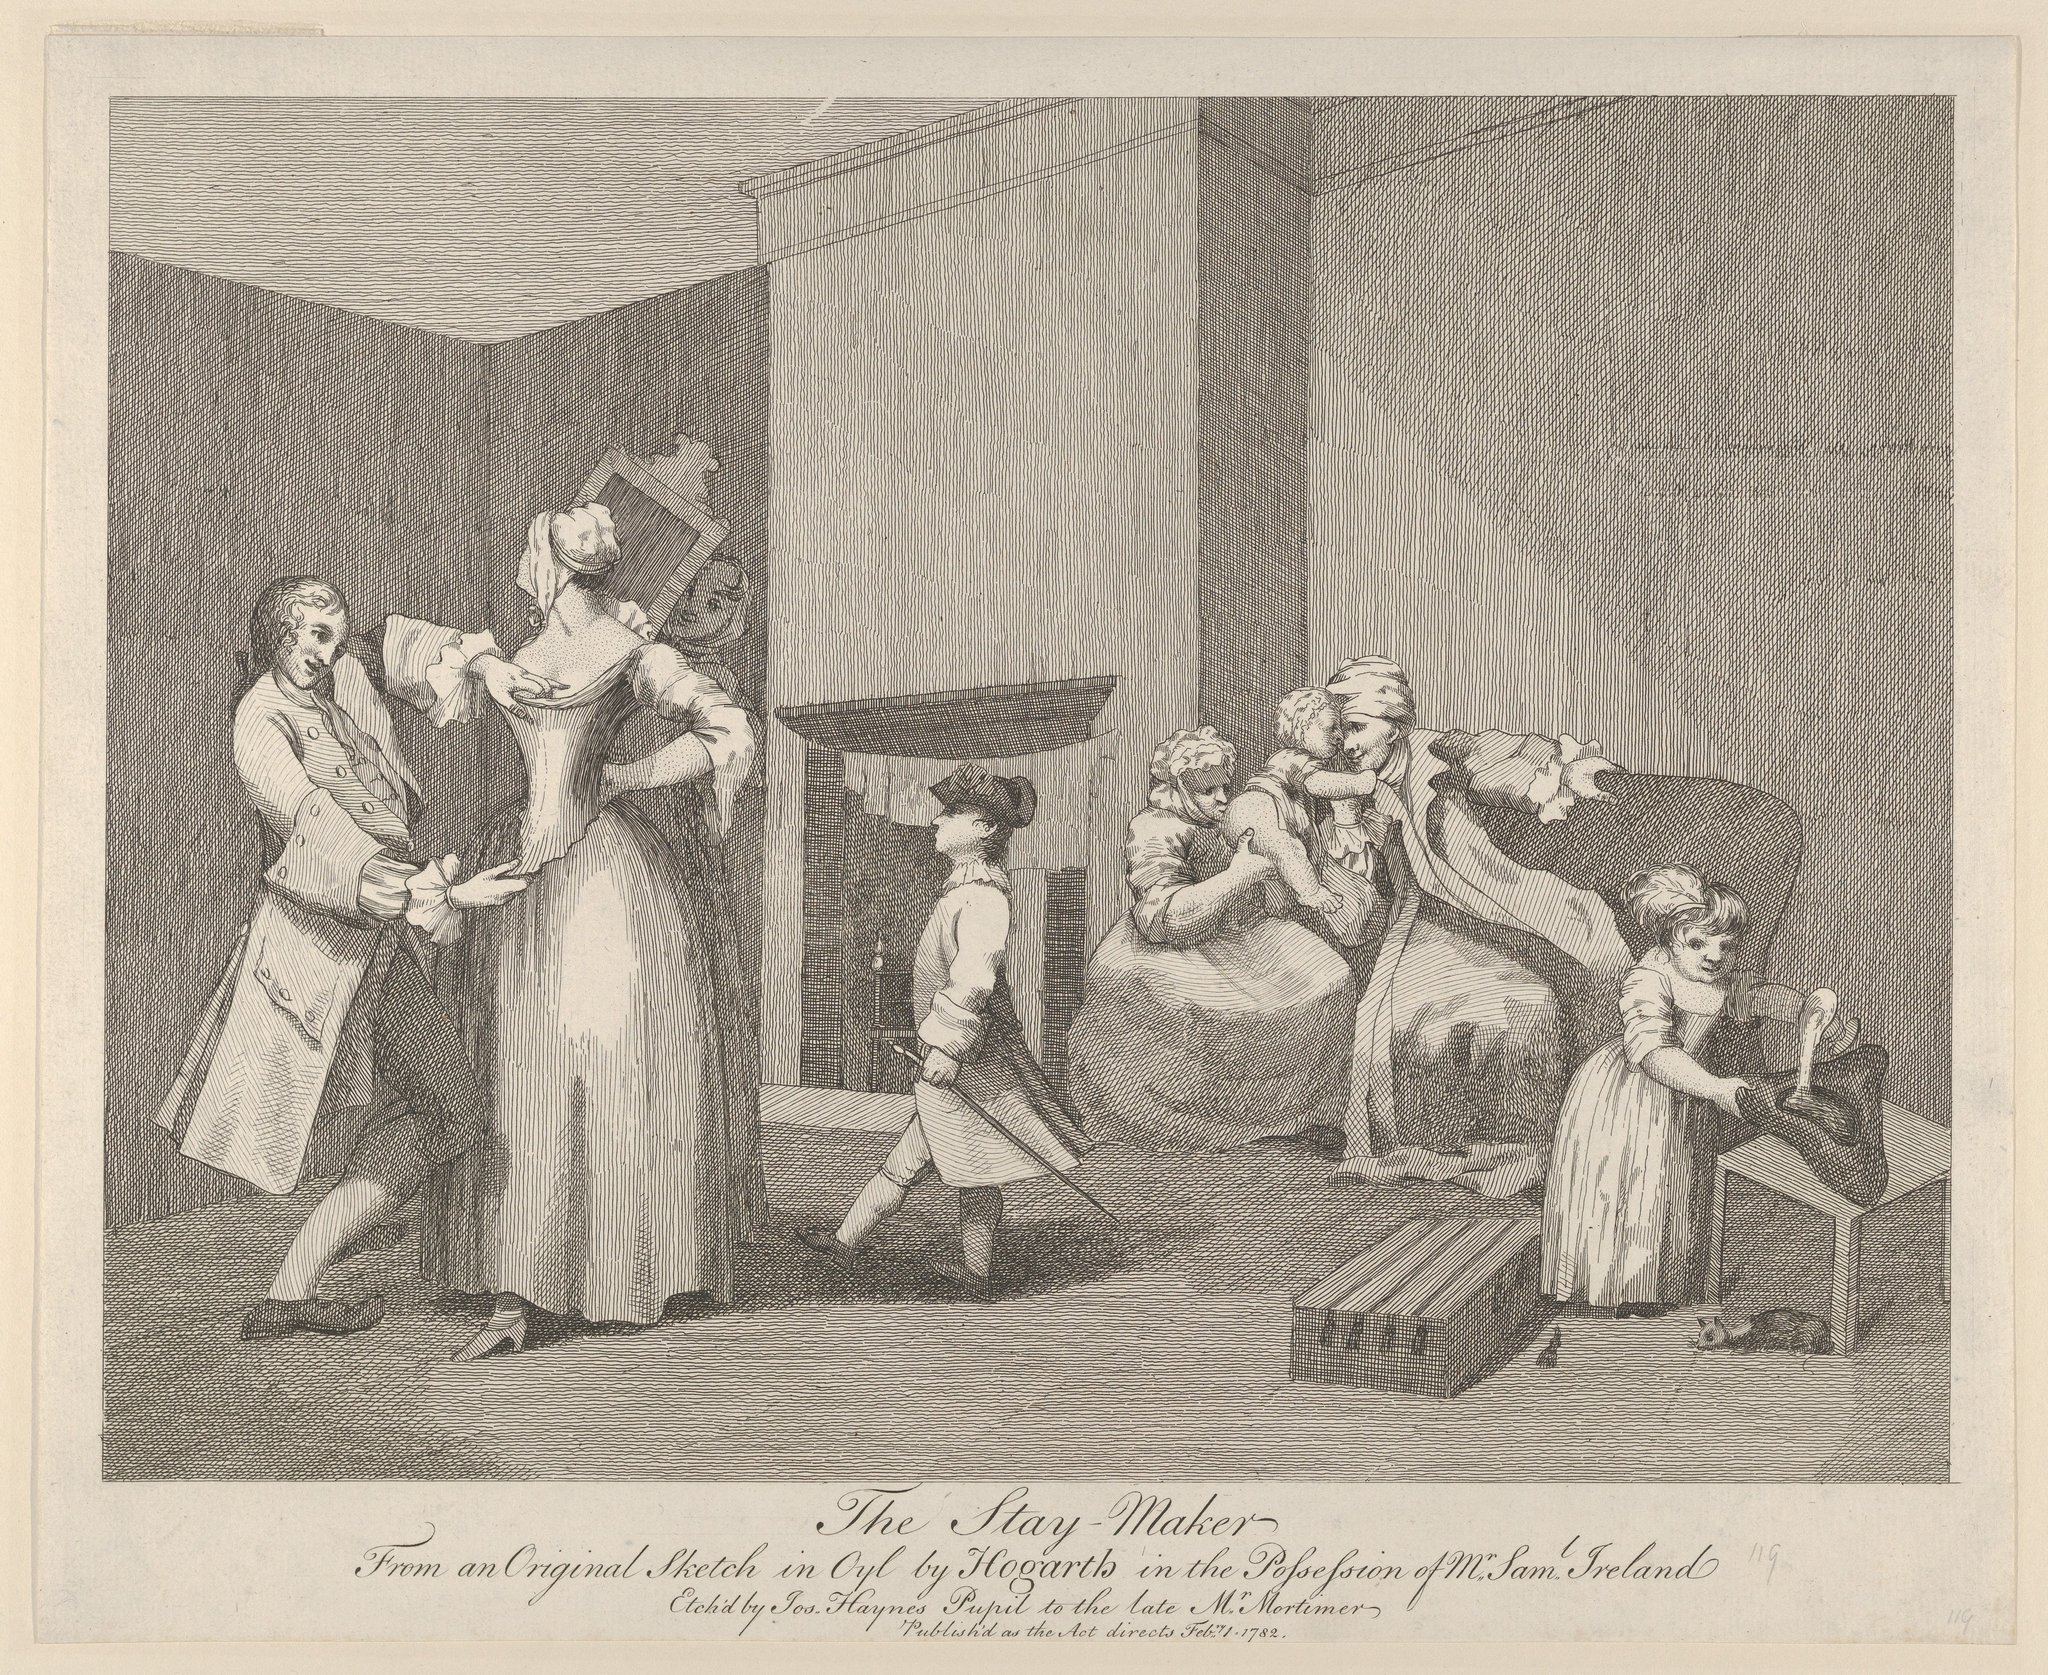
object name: print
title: The Stay-Maker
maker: joseph haynes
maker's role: etcher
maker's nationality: british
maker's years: 1760-1829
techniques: etching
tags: boys,girls,men,women,working